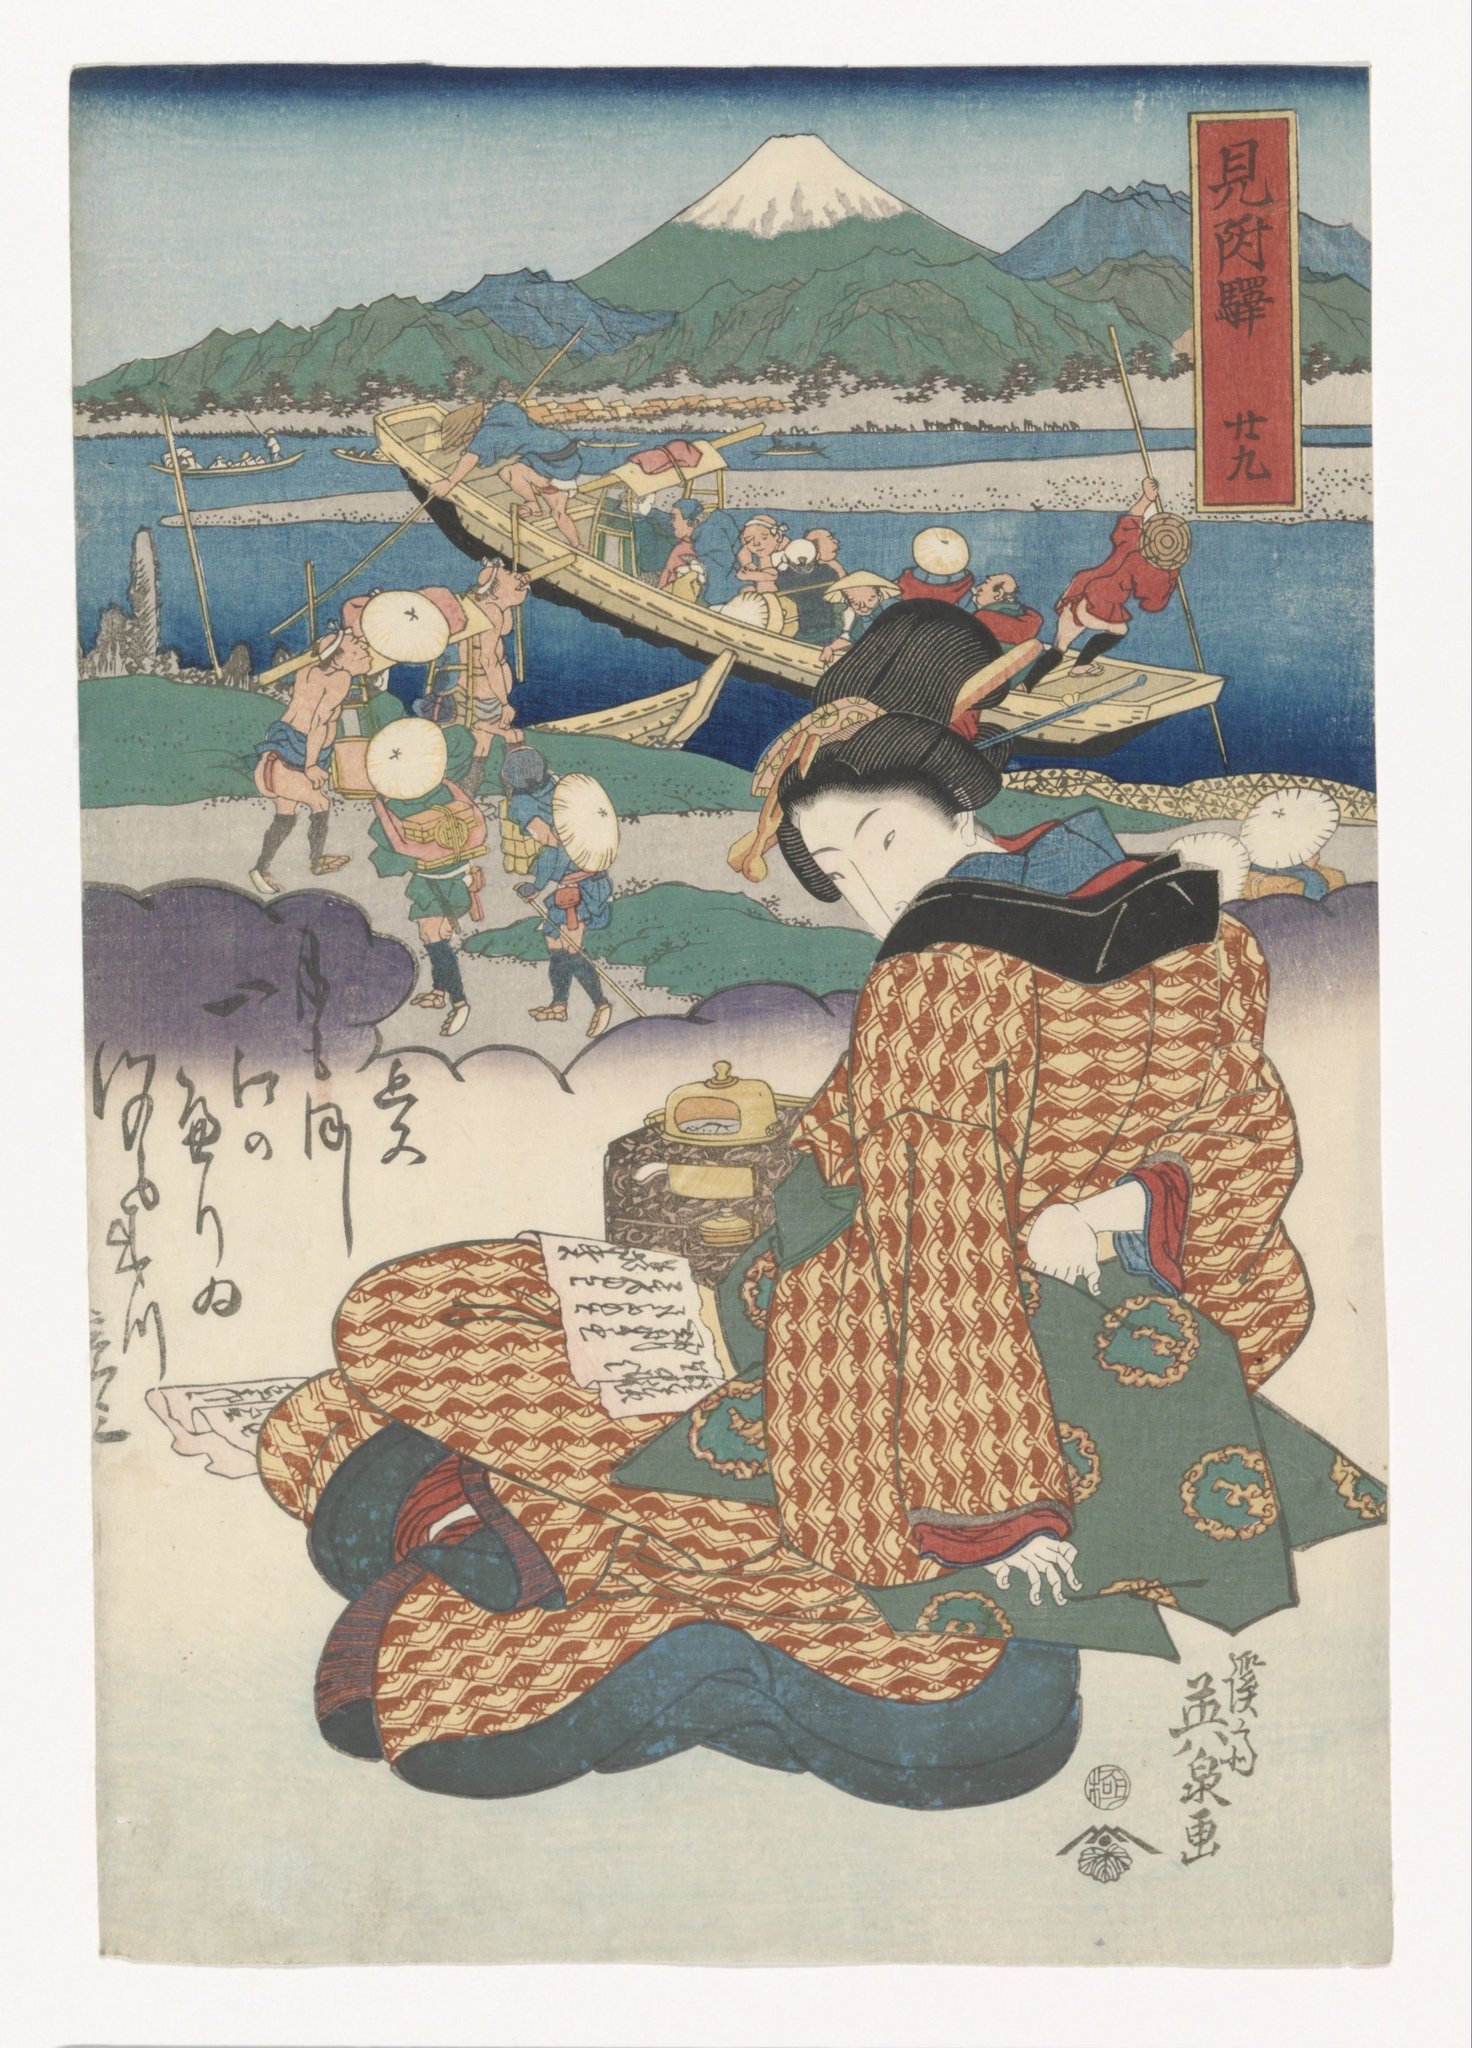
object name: print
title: Brieflezende geisha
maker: keisai eisen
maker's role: print maker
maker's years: 1790-1848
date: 1830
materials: paper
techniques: woodcut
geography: japan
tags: reading, courtesan, hetaera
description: Een brief lezende geisha met op de achtergrond reizigers die de rivier oversteken naar de pleisterplaats Mitsuke gelegen aan de voet van de berg Fuji.